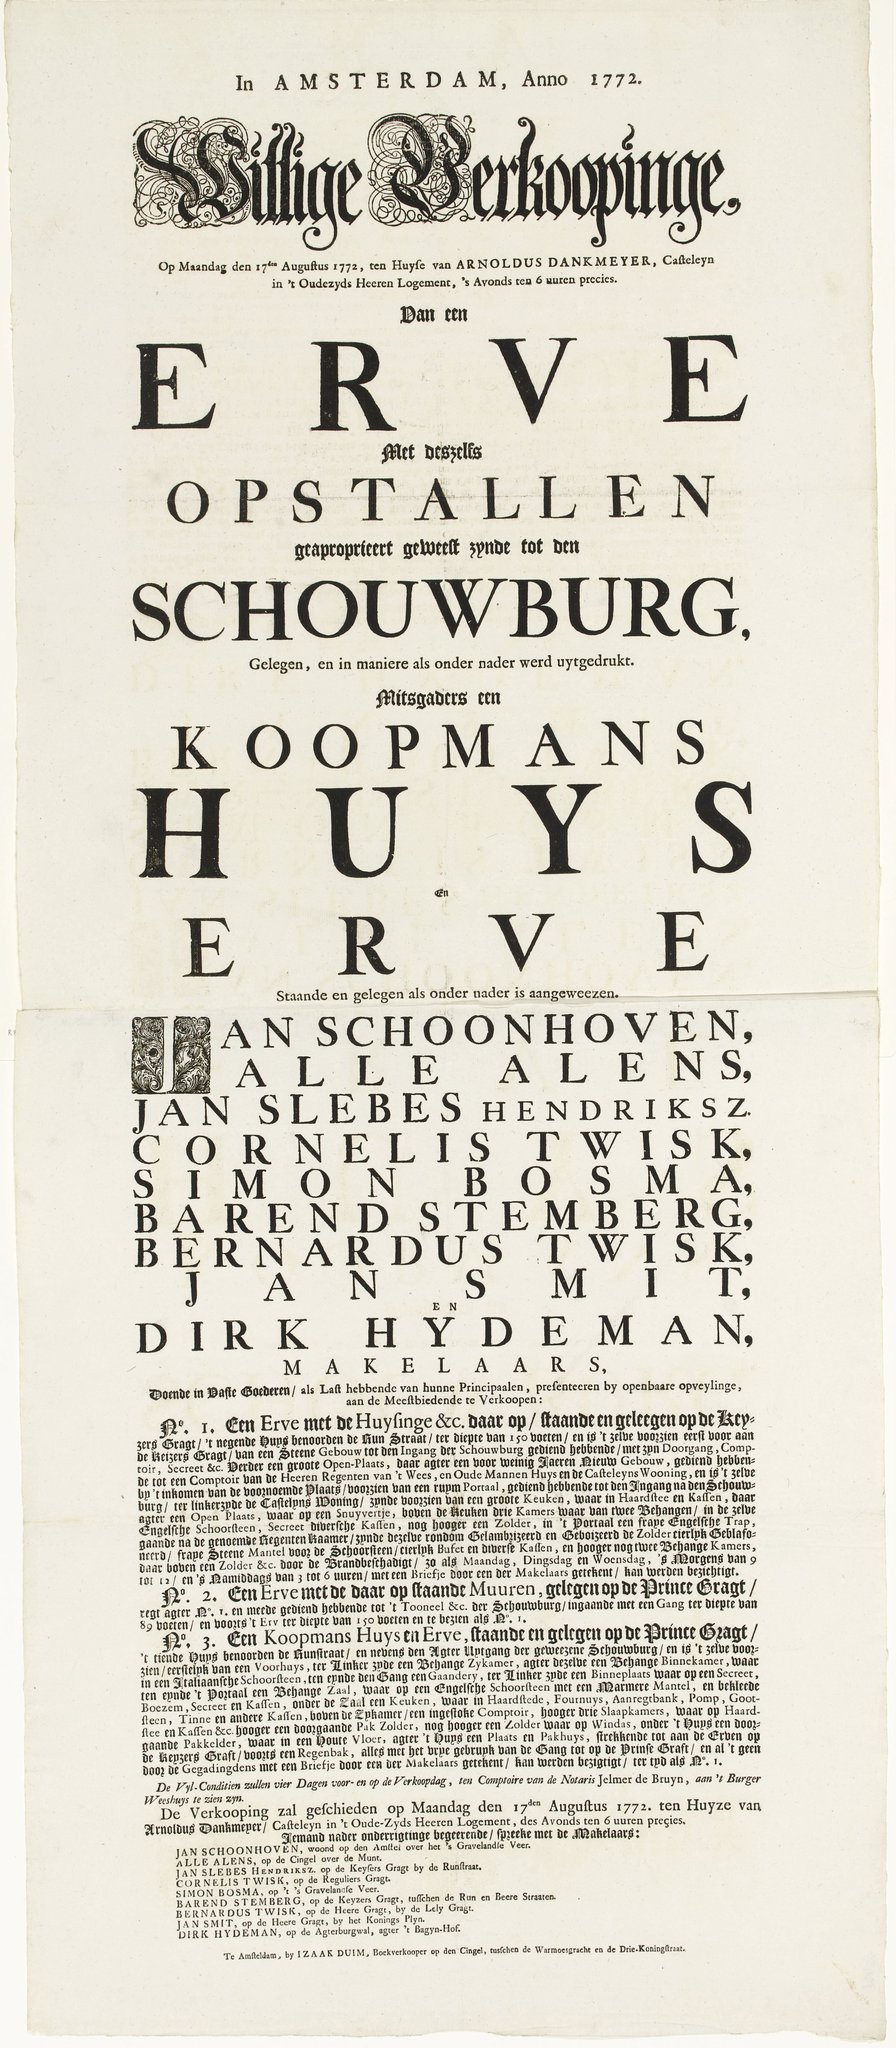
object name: text sheet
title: In Amsterdam, Anno 1772. Willige Verkoopinge, Op Maandag den 17den Augustus 1772, ten Huyse van Arnoldus Dankmeyer, Casteleyn in 't Oudezyds Heeren Logement (...)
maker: izaak duim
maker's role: publisher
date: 1772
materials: paper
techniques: letterpress printing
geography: amsterdam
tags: schouwburg keizersgracht (1637-1772), brand in de amsterdamse schouwburg (1772)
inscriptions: collector's mark: Lugt 2228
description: Bekendmaking van de openbare verkoop op 17 augustus 1772 van de percelen van de op 11 mei 1772 afgebrande Amsterdamse Schouwburg op de Keizersgracht. Onderaan een lijst van de betrokken makelaars. Groot blad bestaande uit twee aan elkaar geplakte bladen.